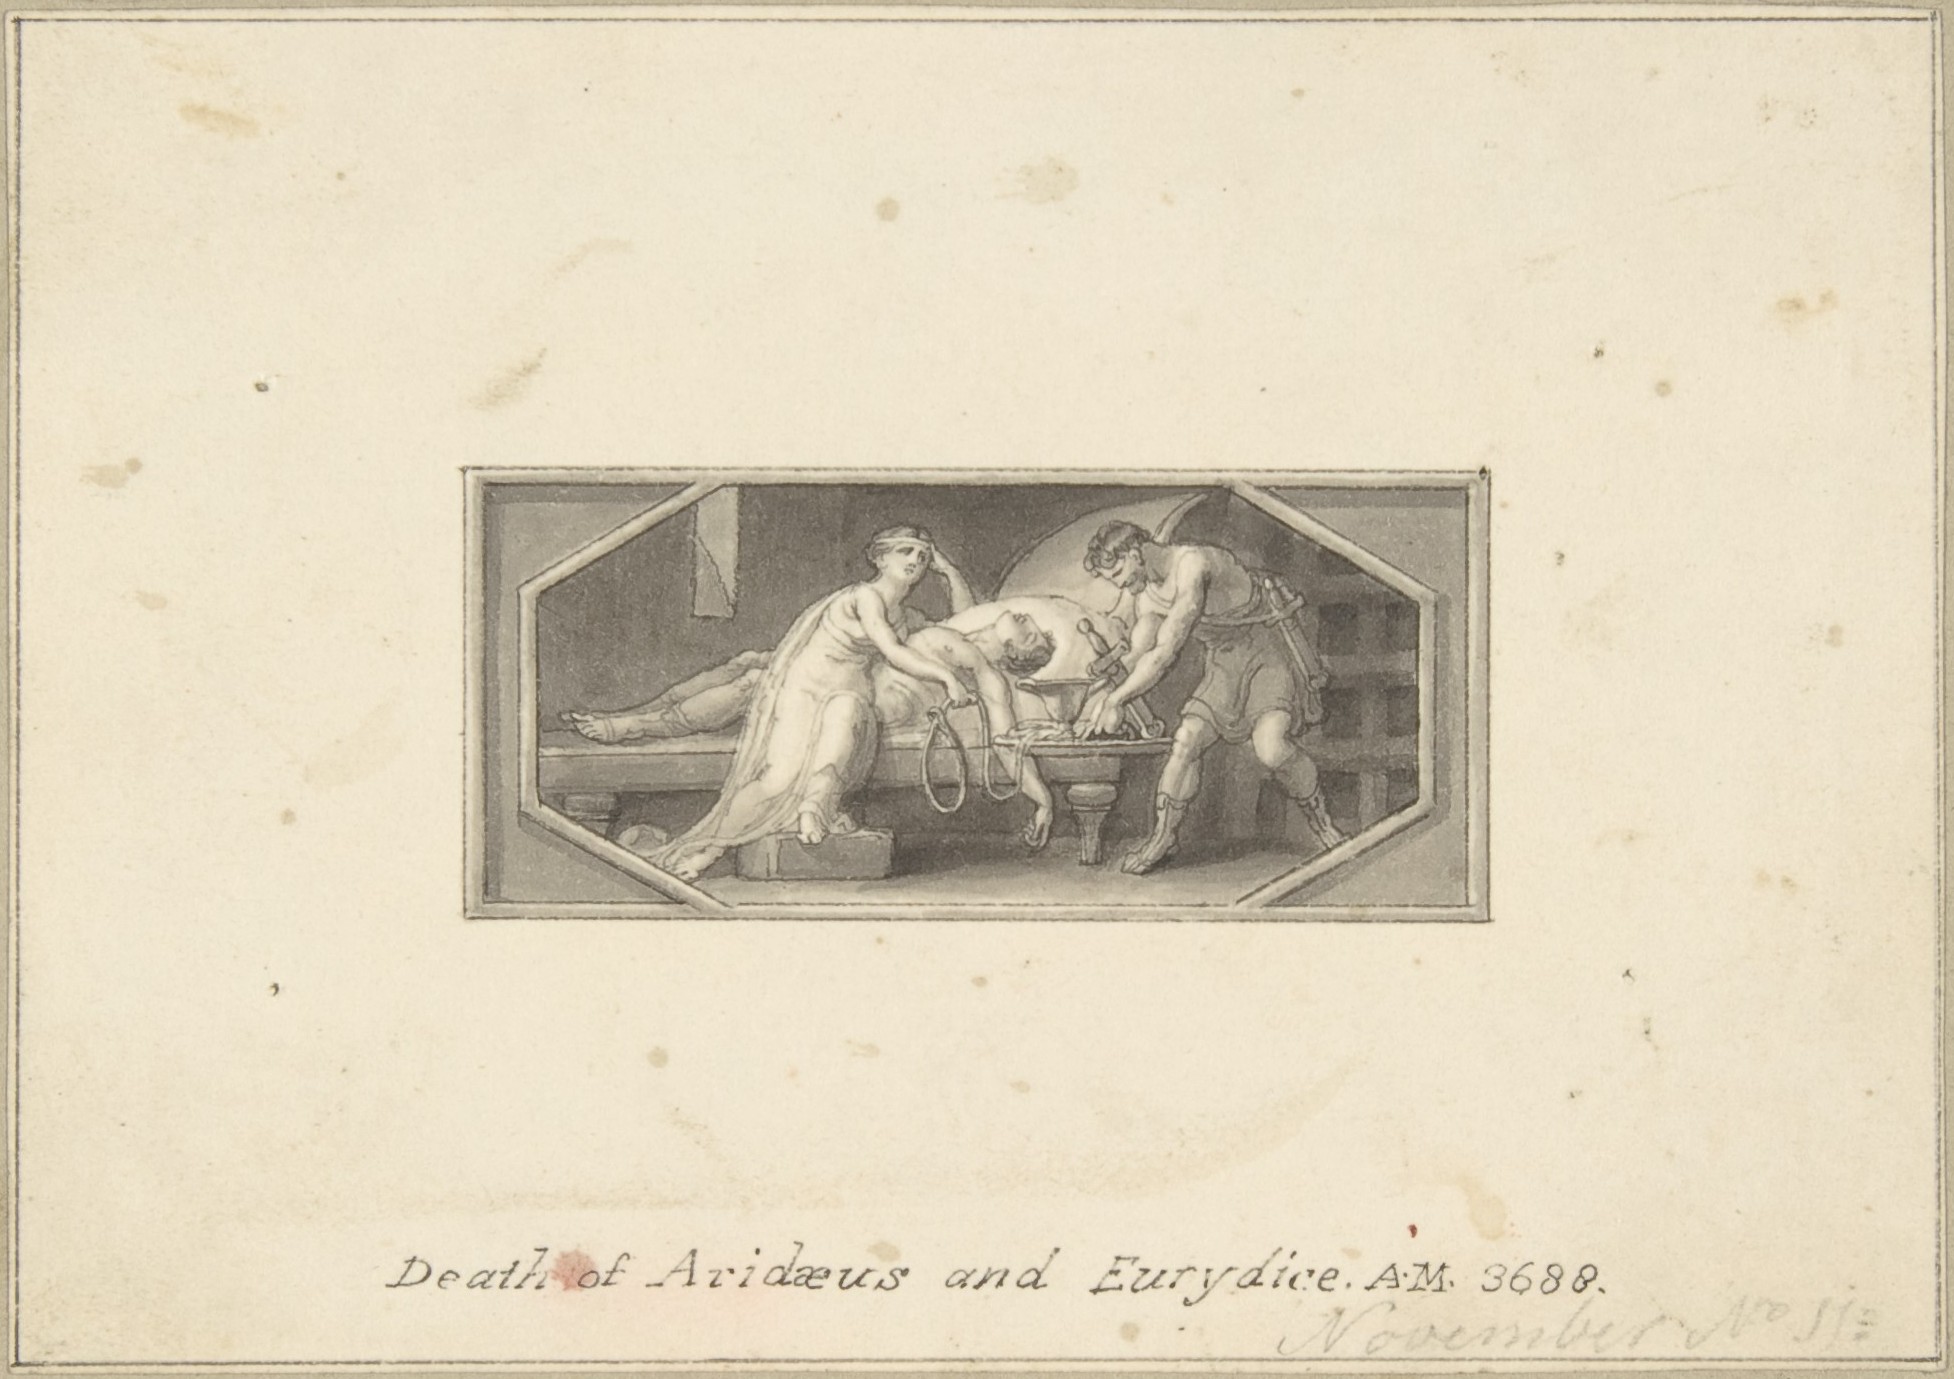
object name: drawing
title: Death of Aridaeus and Eurydice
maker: edward francis burney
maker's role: artist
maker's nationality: british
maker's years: 1760-1848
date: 1790-1800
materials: ink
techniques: brush, pen, wash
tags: men,women,death,eurydice